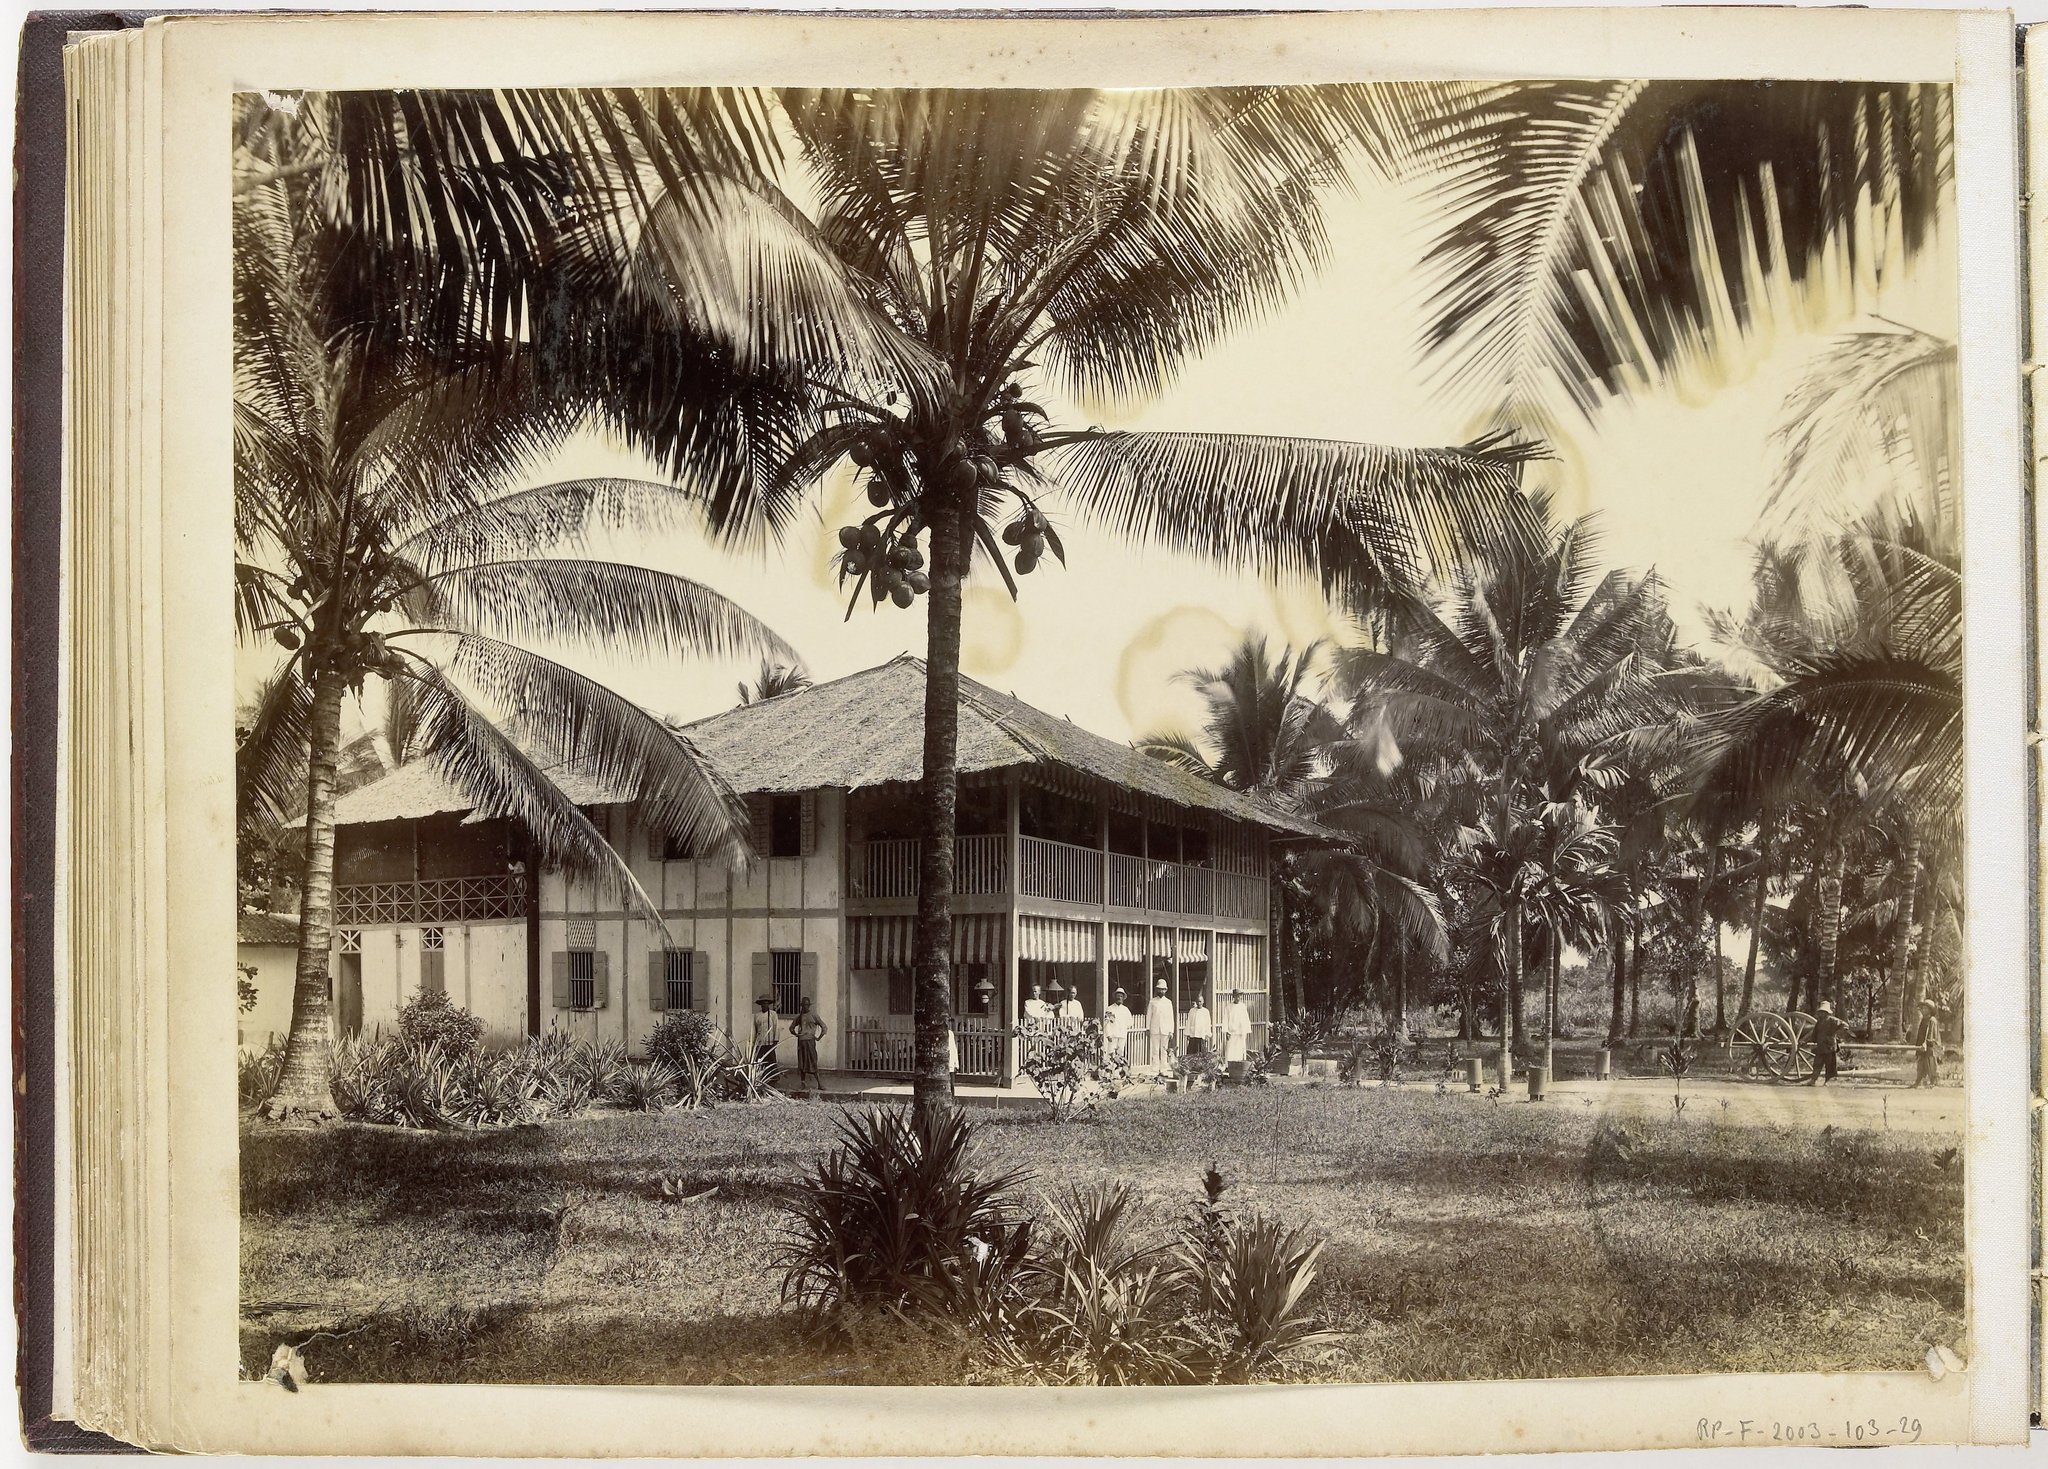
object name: photograph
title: Twee Europese mannen voor huis, Langkat Sumatra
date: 1890-1900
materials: cardboard, paper, photographic support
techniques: albumen print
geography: bindjai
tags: sumatra